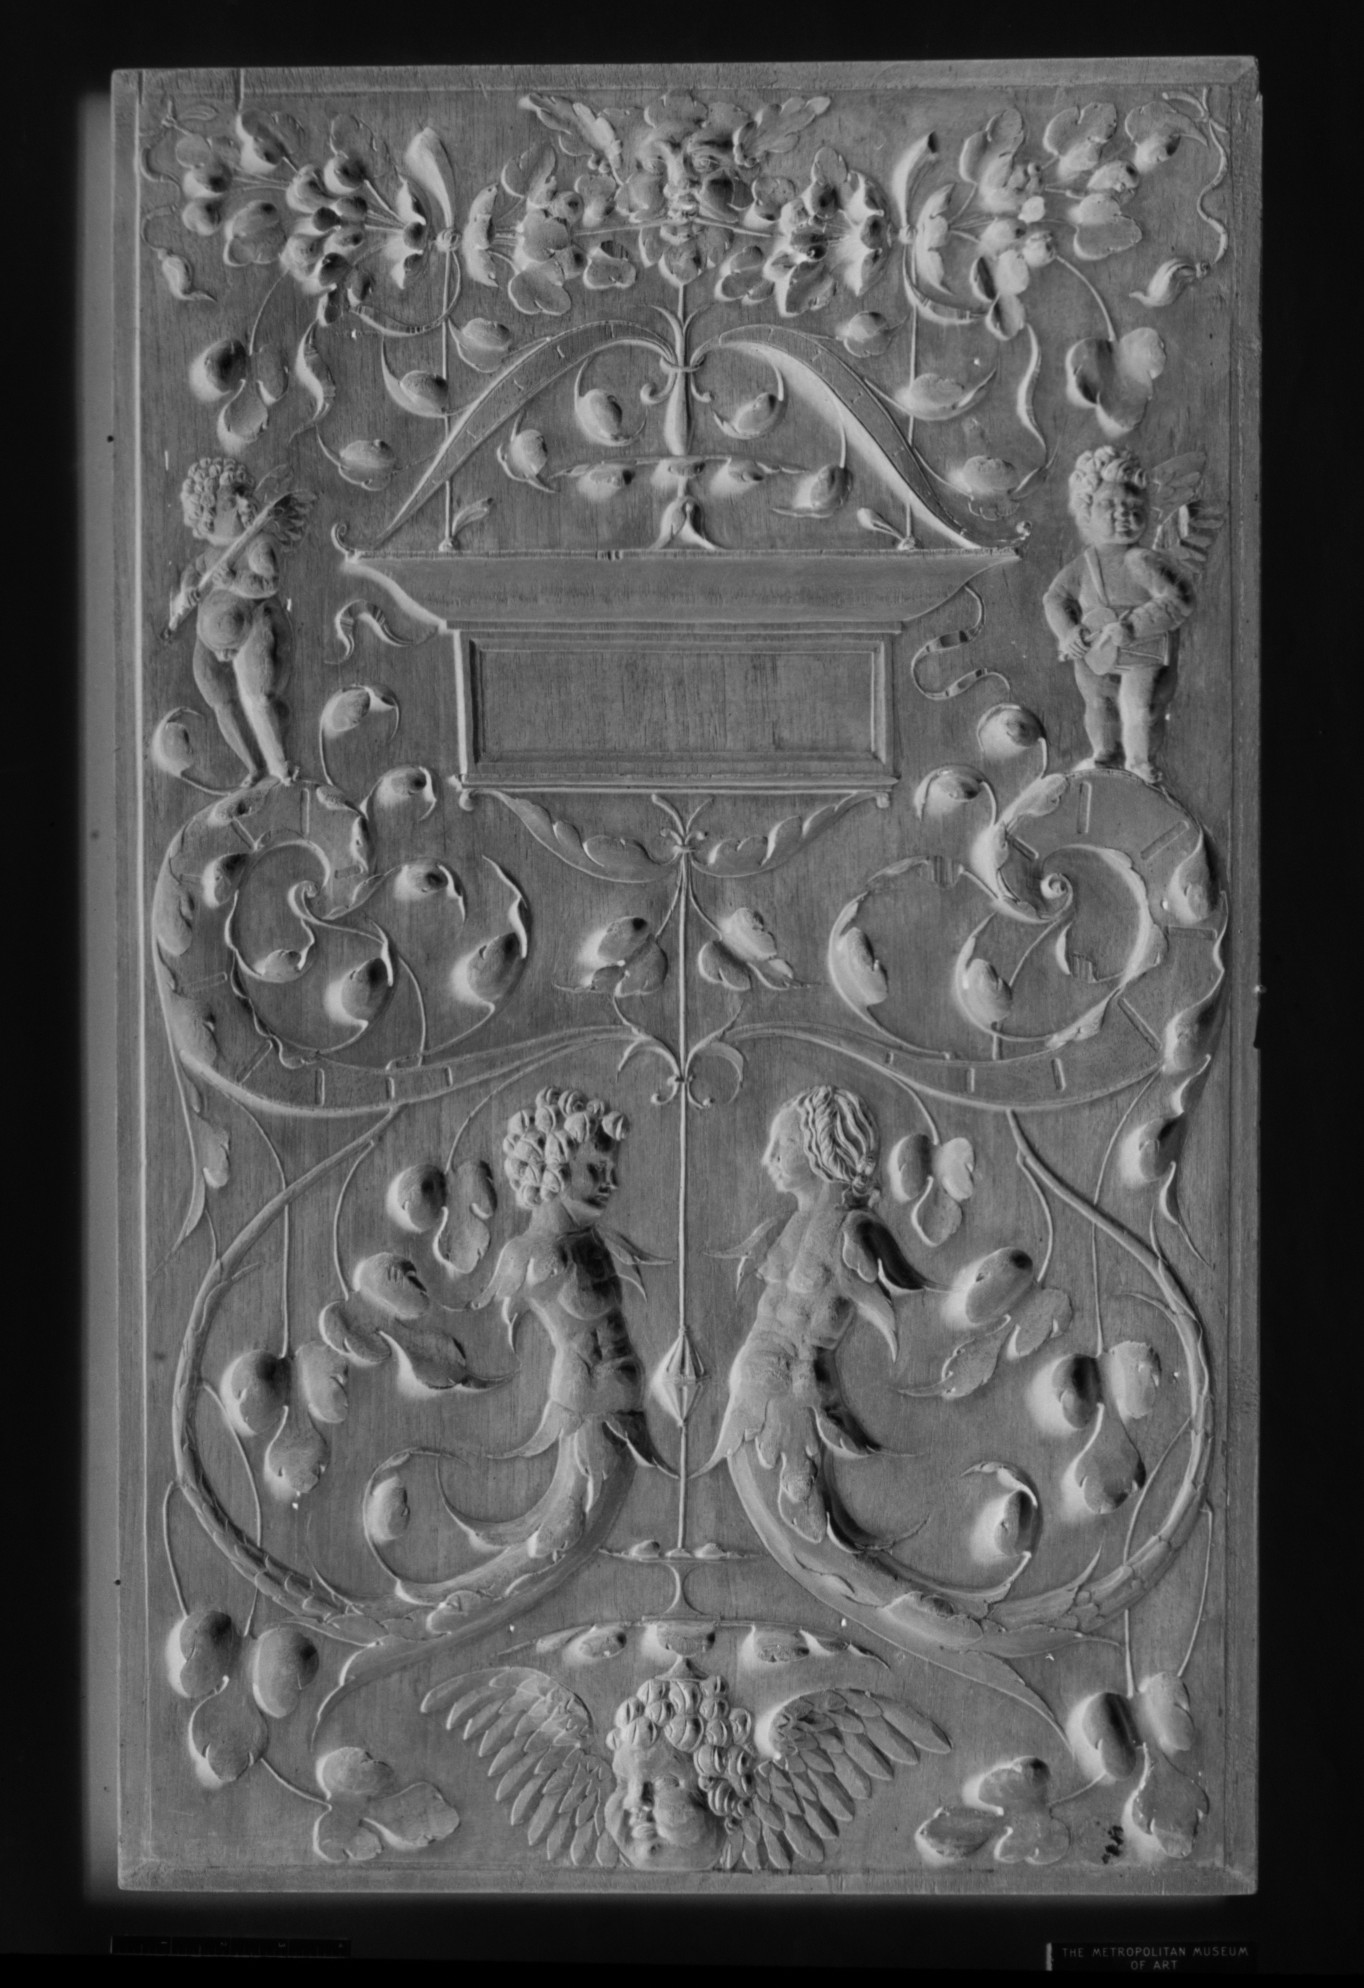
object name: panel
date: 1501-1600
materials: wood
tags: putti